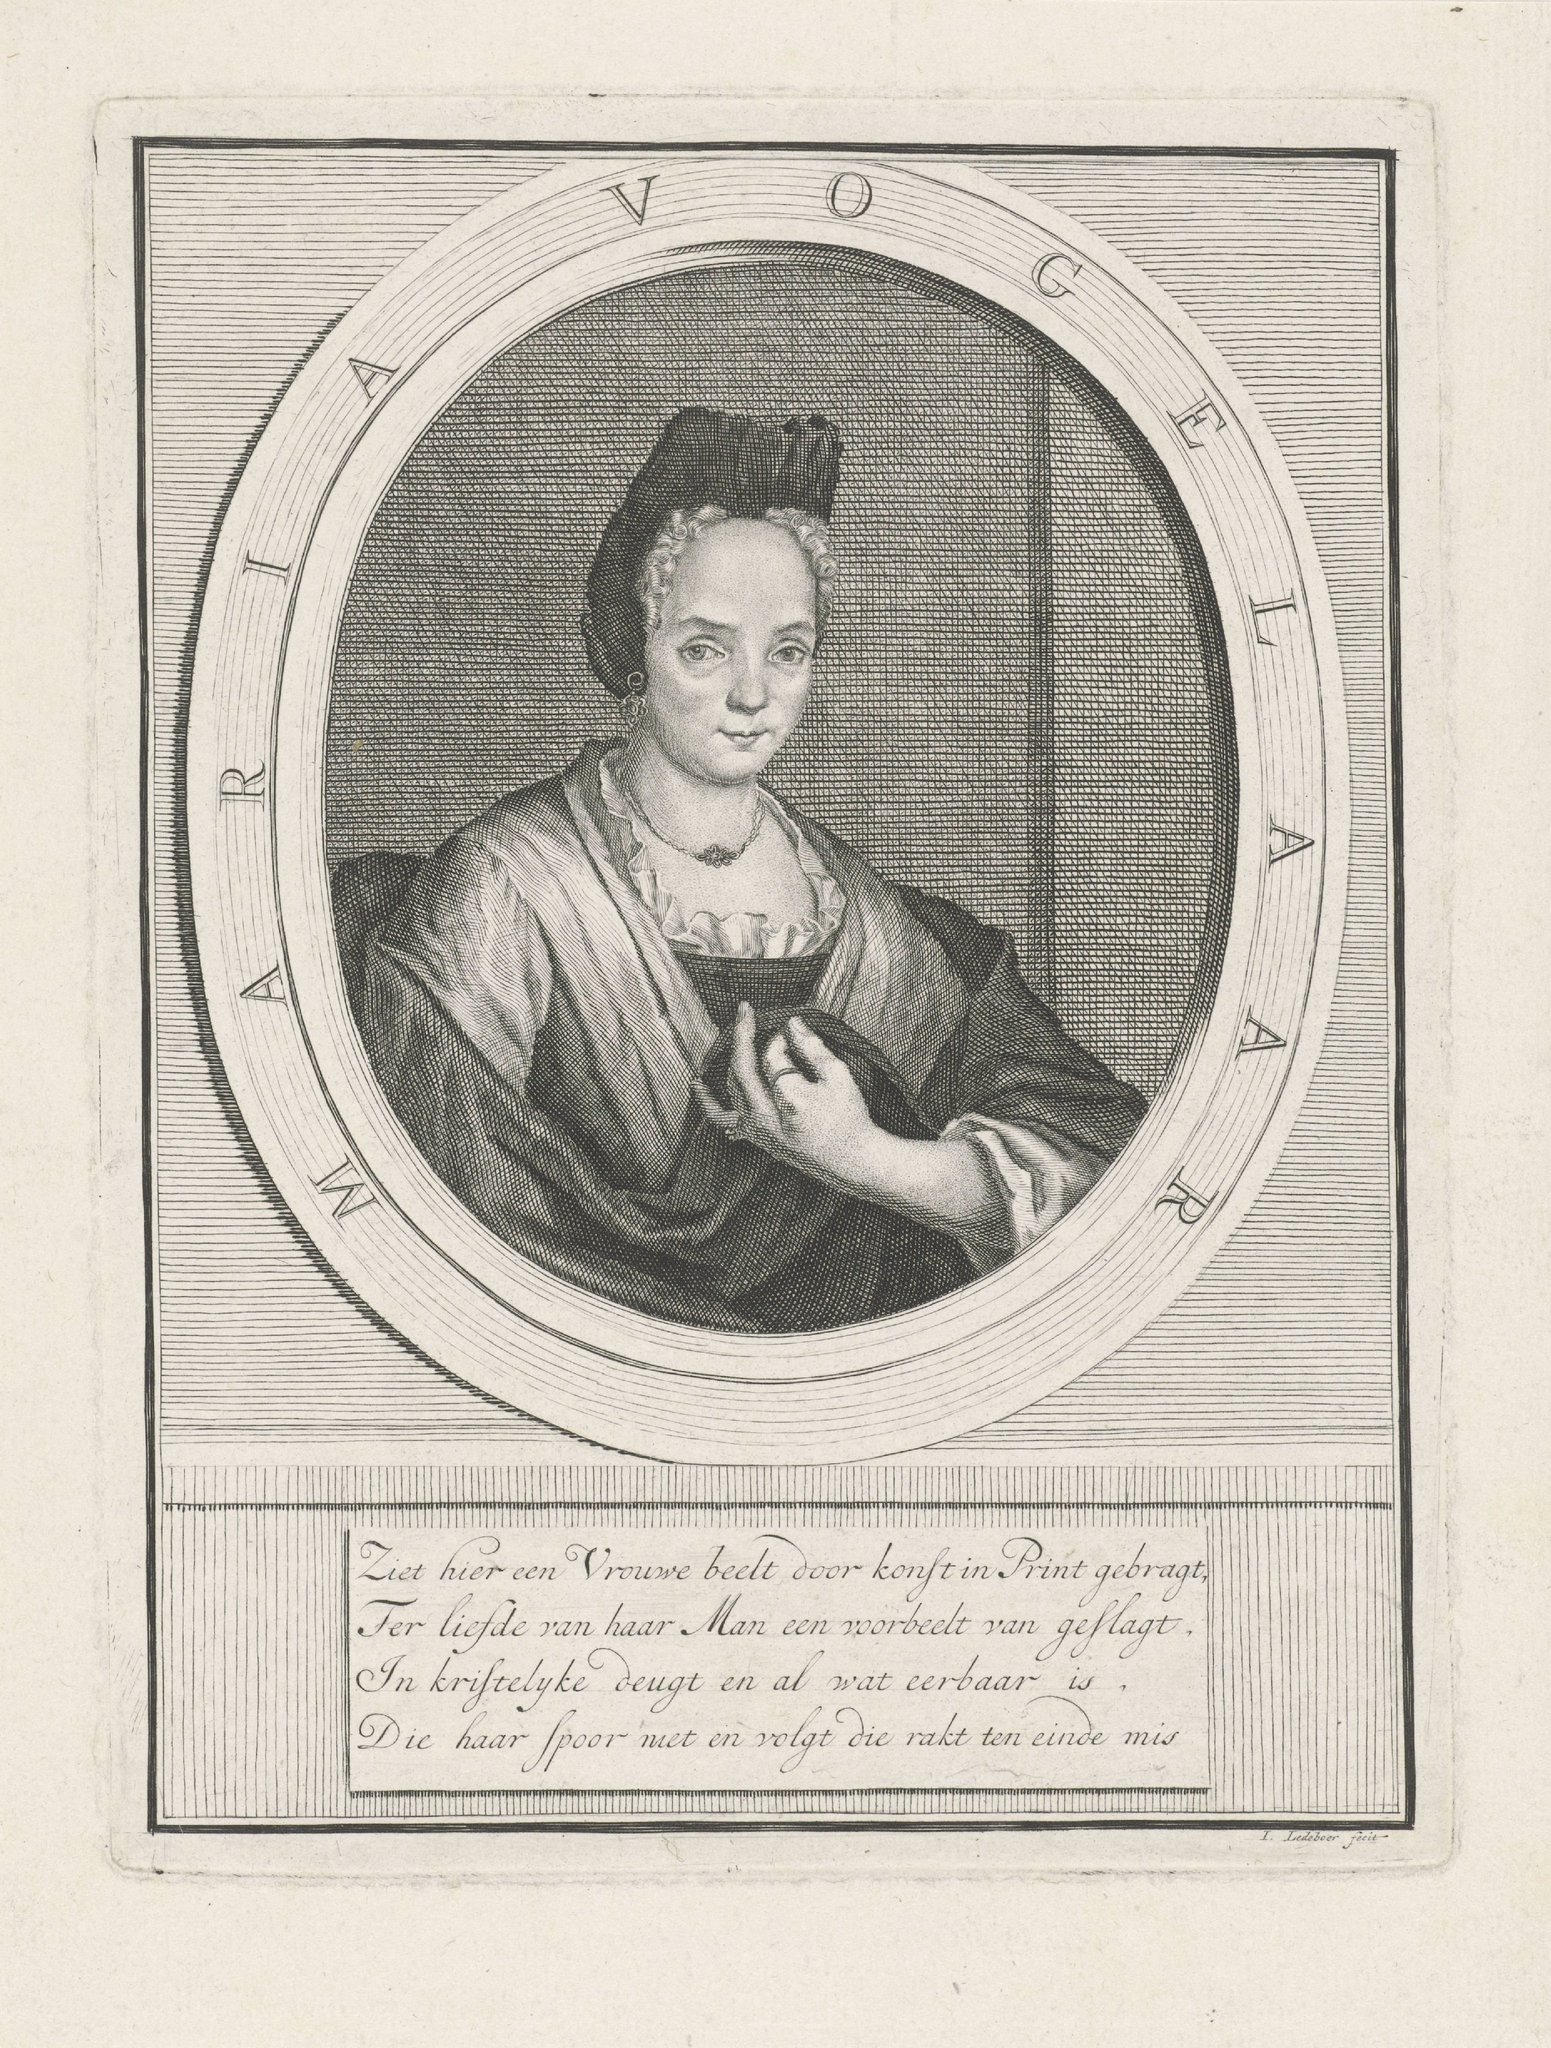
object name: print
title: Portret van Maria Vogelaar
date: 1702-1749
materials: paper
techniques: engraving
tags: maria vogelaar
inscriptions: collector's mark: Lugt 2228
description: Portretbuste in ovaal naar rechts van Maria Vogelaar, echtgenote van Ernst Jan Ledeboer, met opstaand mutsje. Met randschrift en een vierregelig Nederlands vers.